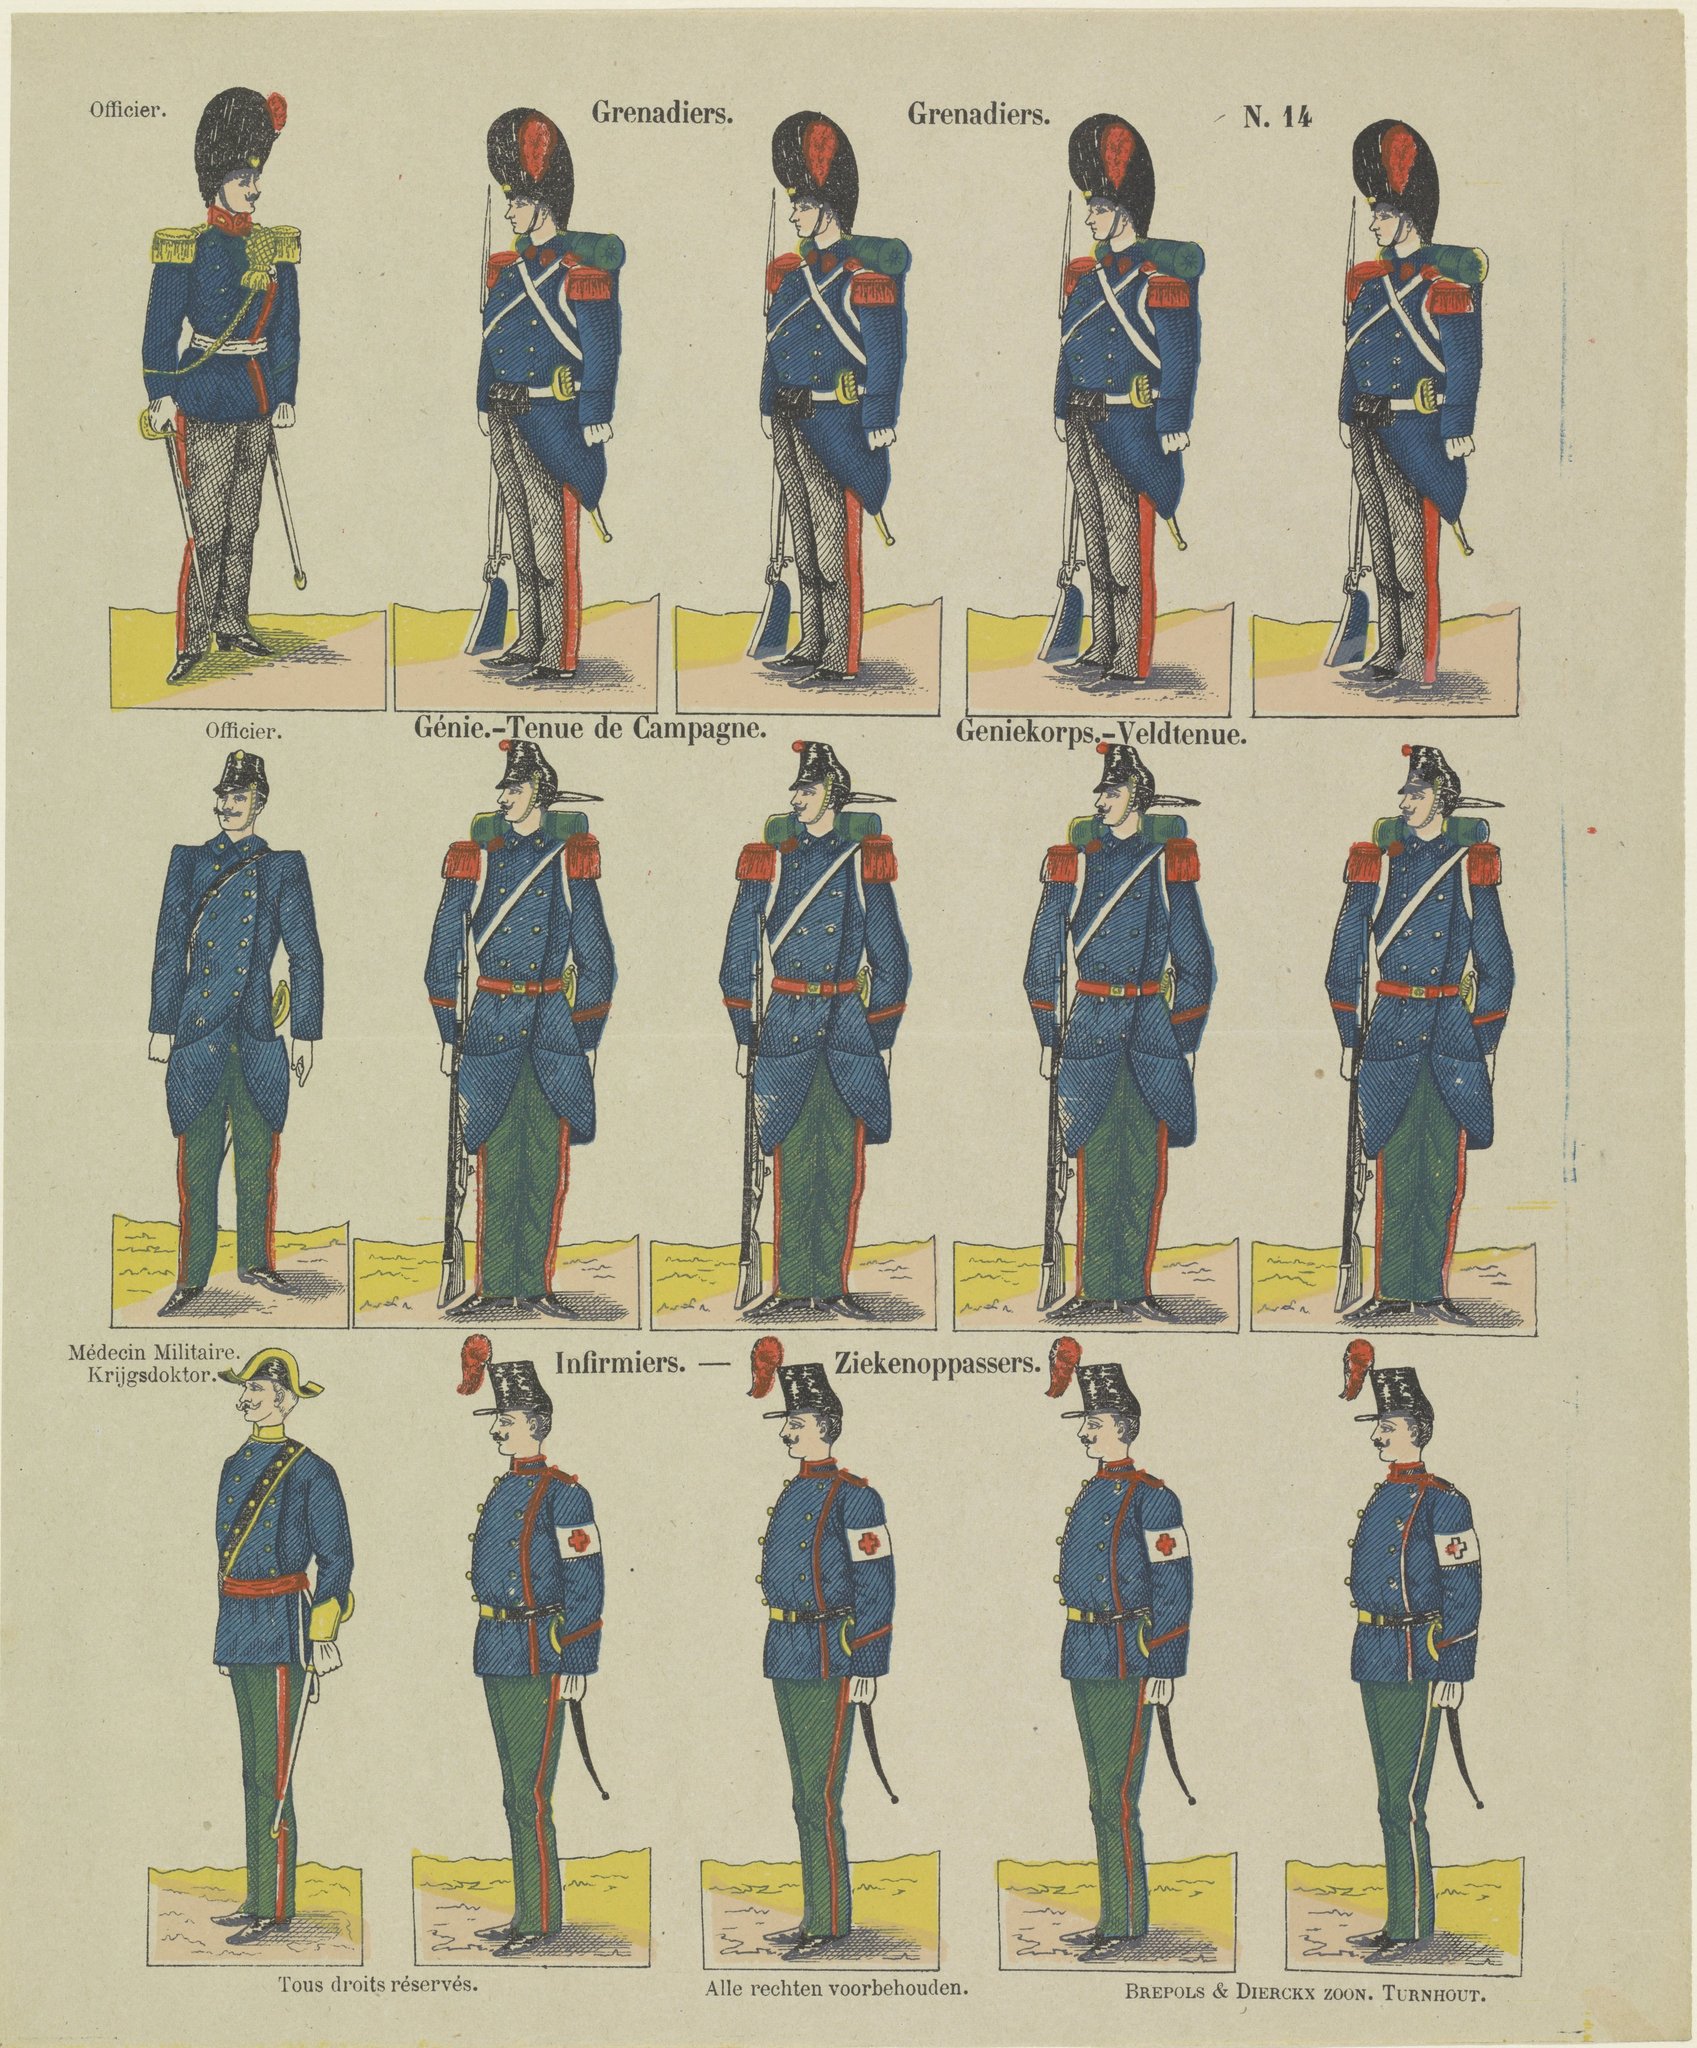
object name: print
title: Grenadiers / Grenadiers / Génie.-Tenue de Campagne / Geniekorps.-Veldtenue / Infirmiers / Ziekenoppassers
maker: Anonymous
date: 1833-1911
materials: paper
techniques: lithograph, letterpress printing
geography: turnhout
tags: physician, doctor, the soldier; the soldier's life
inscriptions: collector's mark: Lugt 2760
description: Blad met 3 horizontale rijen met in totaal 15 voorstellingen van officieren, militairen met geweren, een krijgsdokter en ziekenoppassers. Genummerd rechtsboven: N. 14.